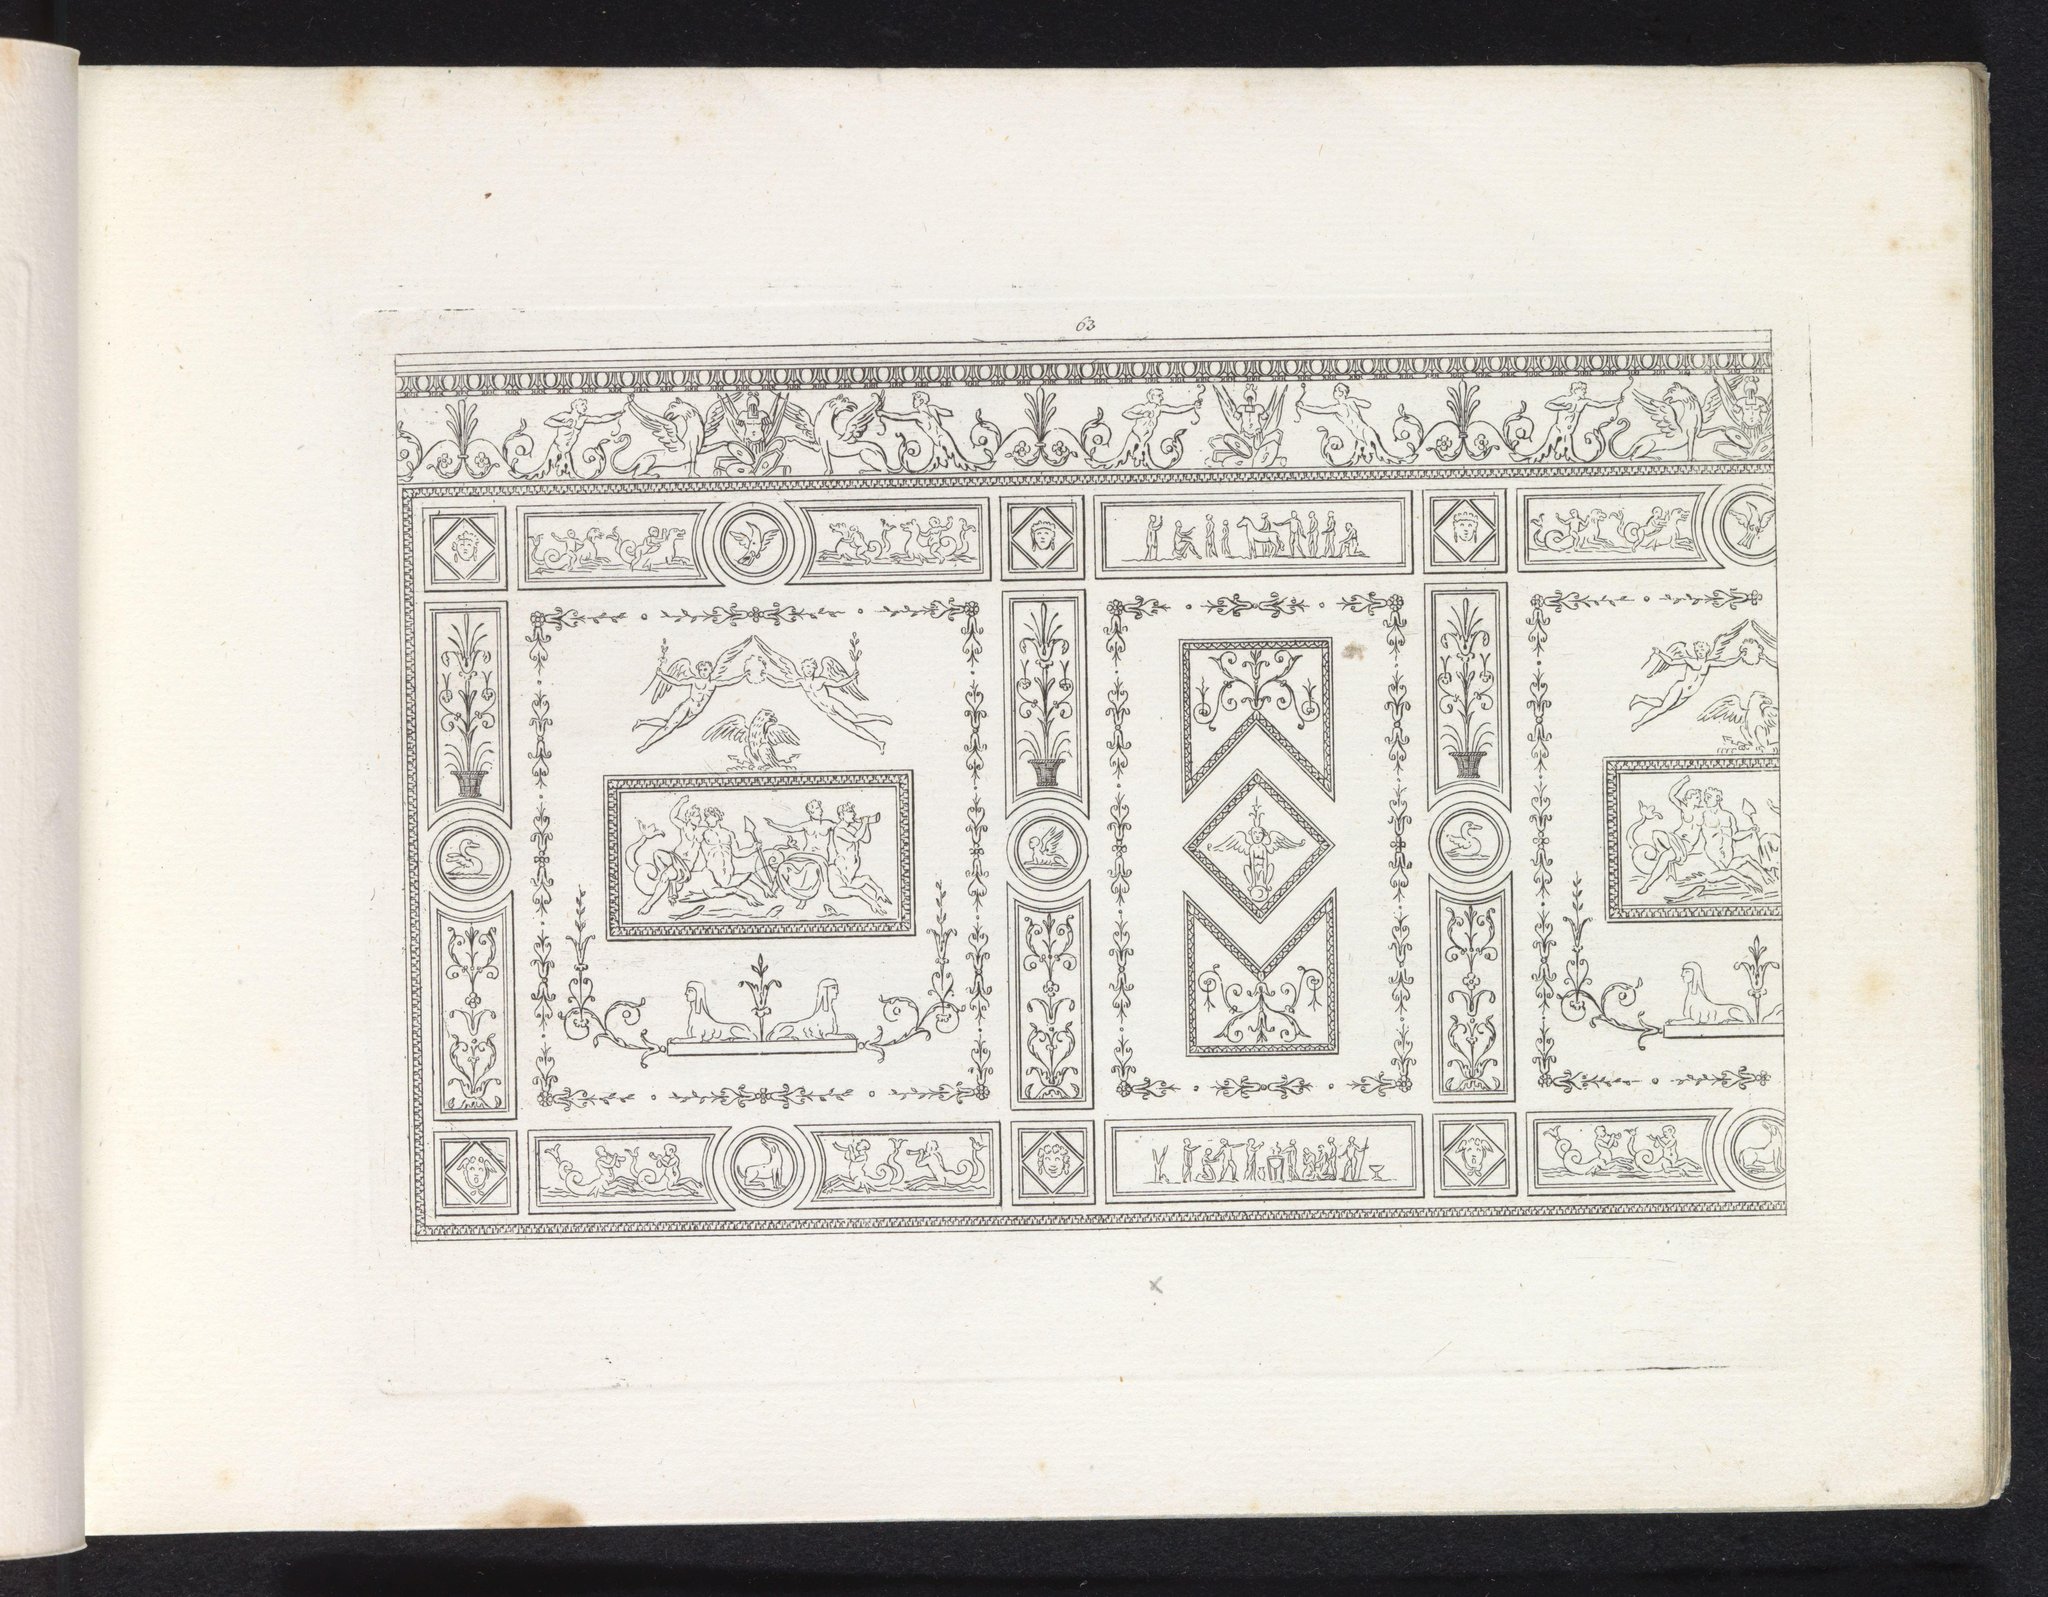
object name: album leaf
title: Ontwerpen voor religieuze en profane voorwerpen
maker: pietro ruga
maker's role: print maker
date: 1817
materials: paper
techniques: etching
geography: milan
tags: ornaments ~ art, panelling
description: Prent maakt deel uit van een reeks van 100 prenten (+ titelprent) met ontwerpen voor religieuze en profane voorwerpen.